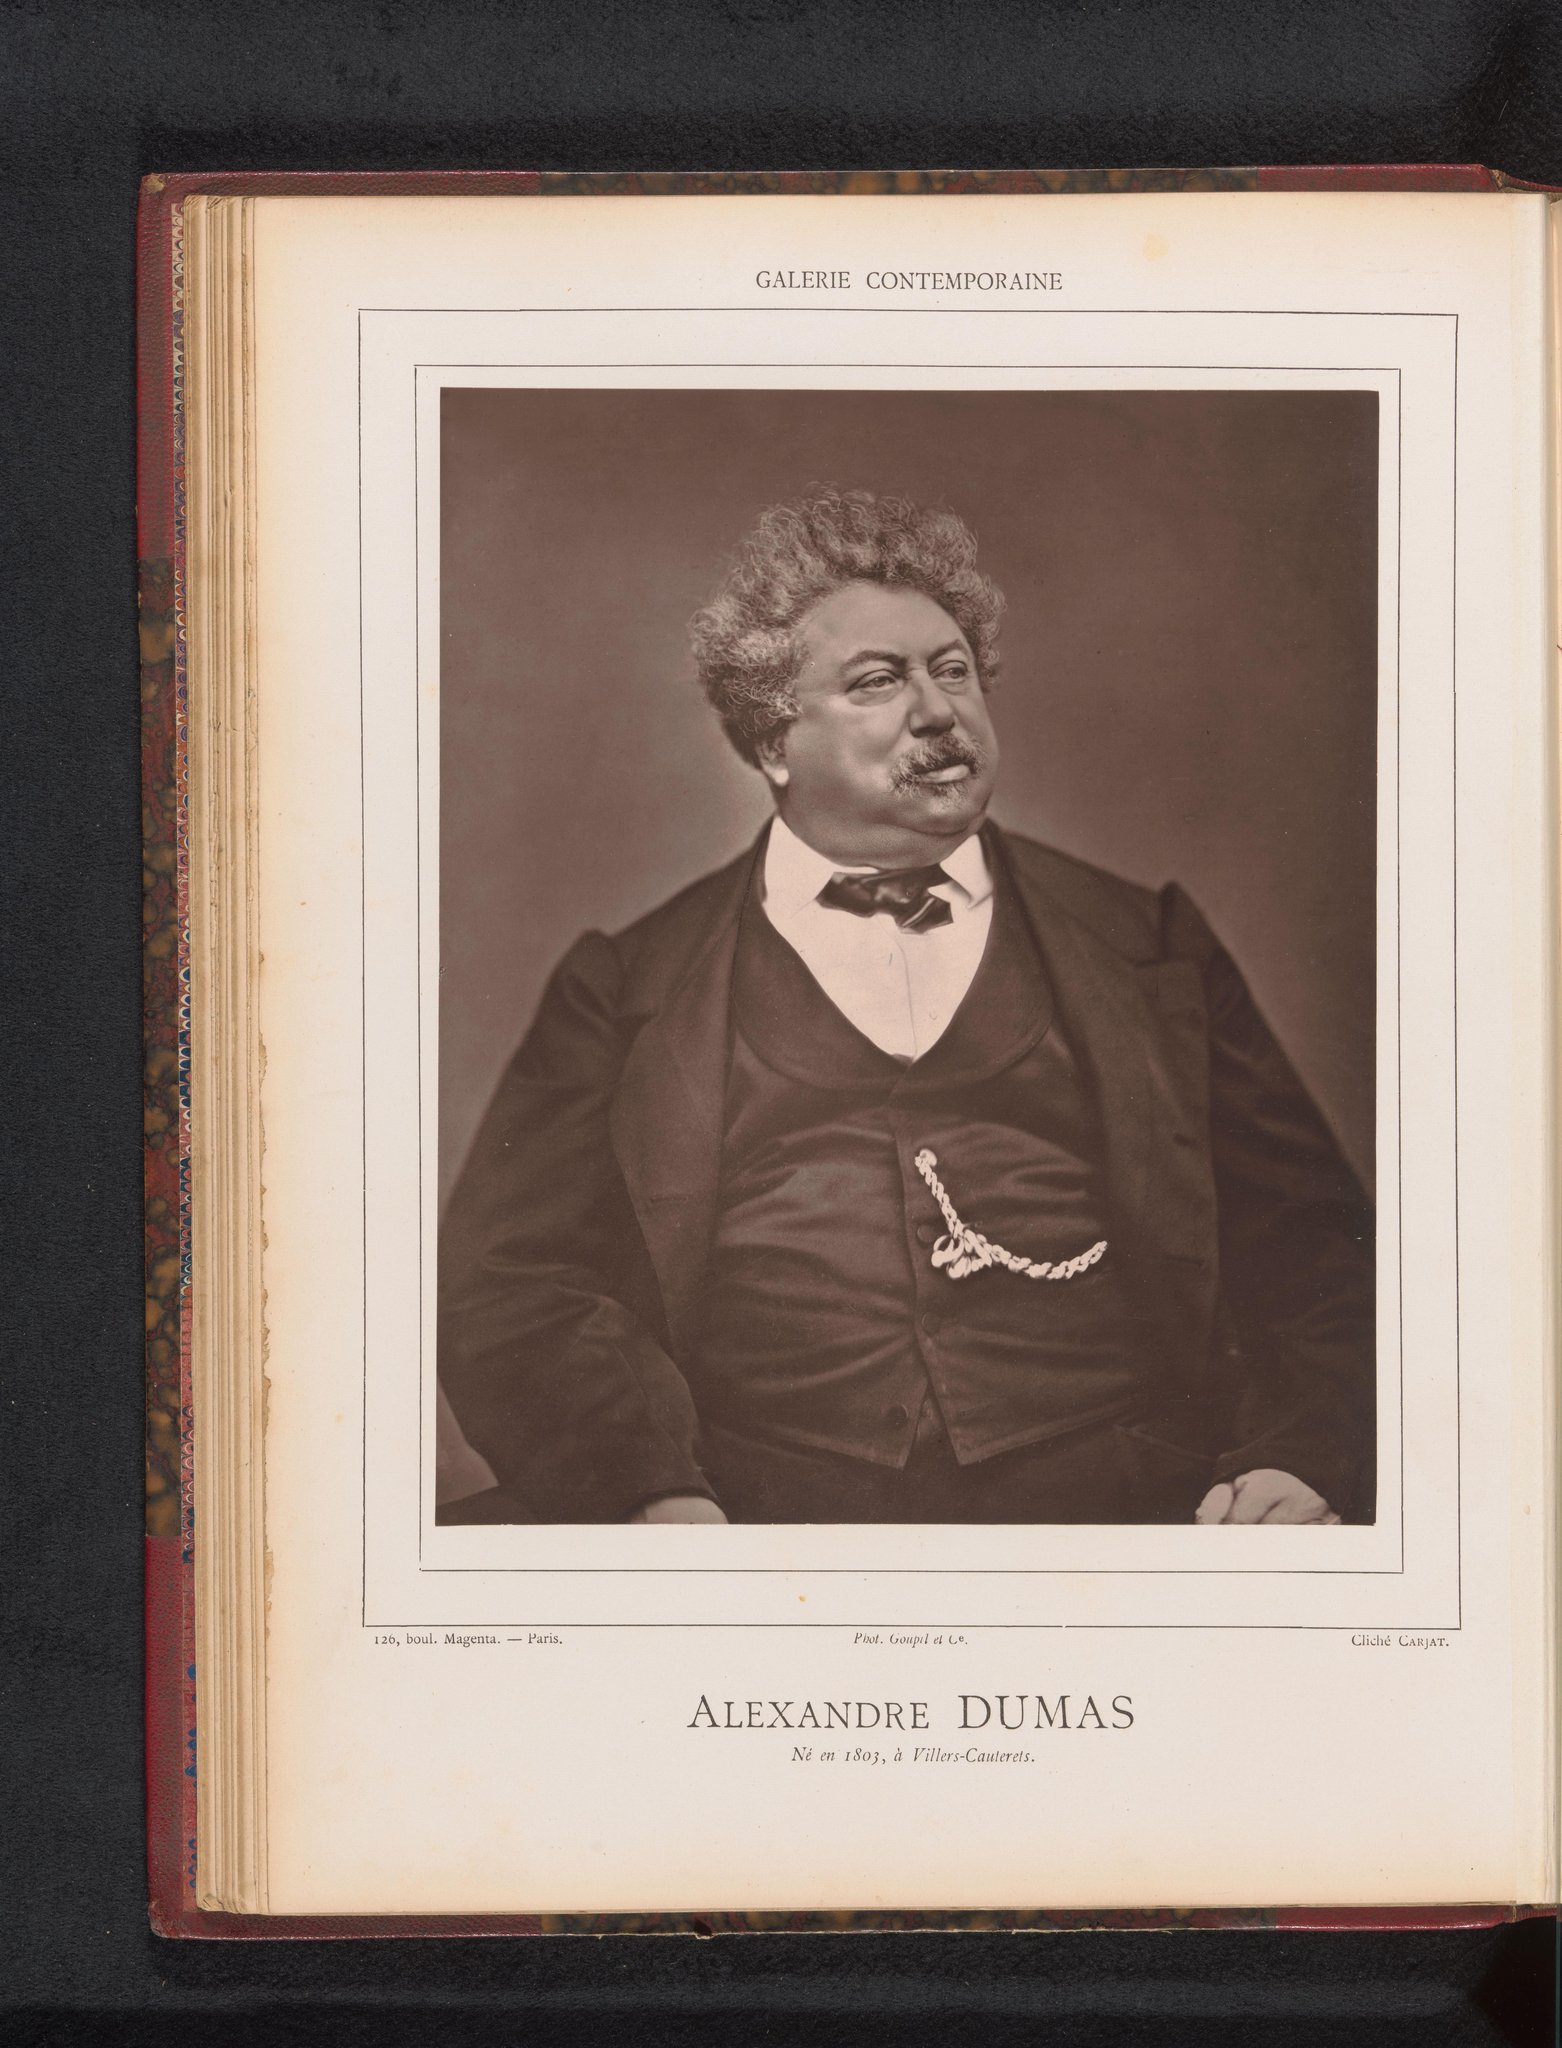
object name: page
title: Alexandre Dumas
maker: étienne carjat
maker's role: draughtsman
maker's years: 1828-1906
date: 1878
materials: paper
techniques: woodburytype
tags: historical persons, portrait of a writer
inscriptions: inscription: ‘Galerie contemporaine/ Né en 1803, à Villers-Cauterets’